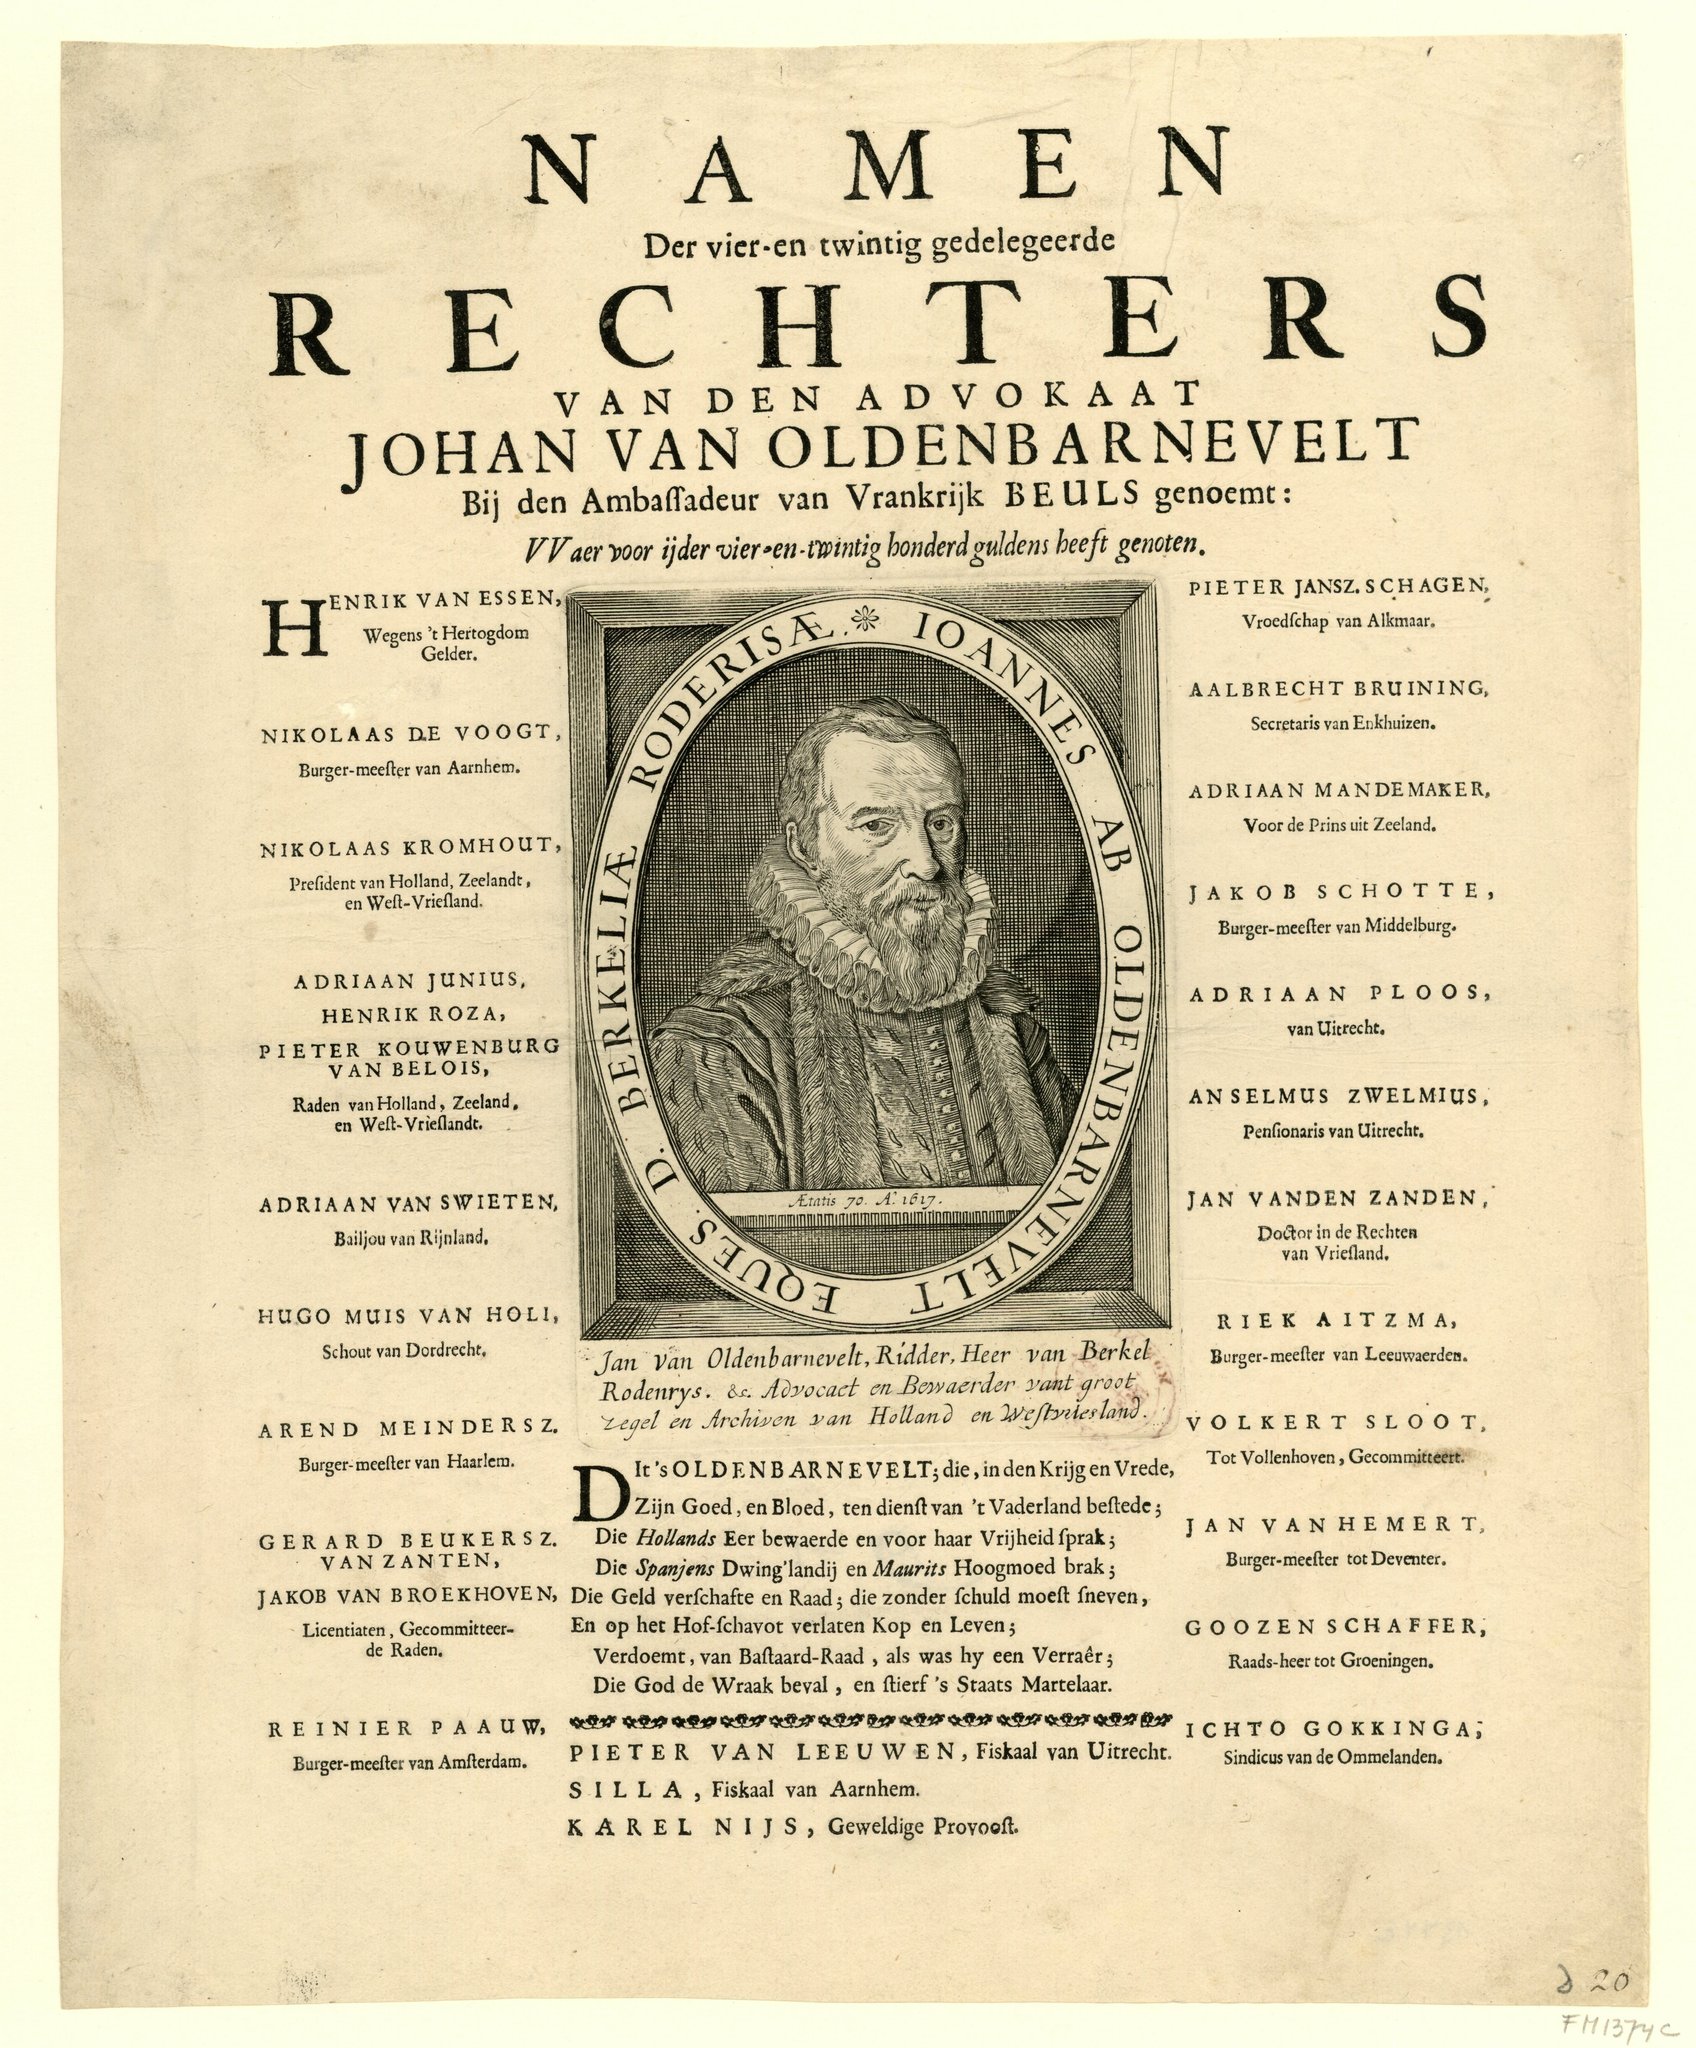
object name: print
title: Namen der vier-en twintig gedelegeerde Rechters van den advokaat Johan van Oldenbarnevelt Bij den Ambassadeur van Vrankrijk Beuls genoemt: Waer voor ijder vier-en-twintig honderd guldens heeft genoten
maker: Anonymous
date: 1619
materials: paper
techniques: engraving, letterpress printing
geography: northern netherlands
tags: johan van oldenbarnevelt, historical persons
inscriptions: collector's mark: Lugt 240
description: Blad met een portret van Johan van Oldenbarnevelt, omringd door de namen van de vierentwintig rechters die hem ter dood hebben veroordeeld. Met randschrift in het Latijn en in de plaat onder het portret een Nederlands onderschrift van drie regels. Onder de prent staat een vers waarin de eer en onschuld van de landsadvocaat worden geroemd.